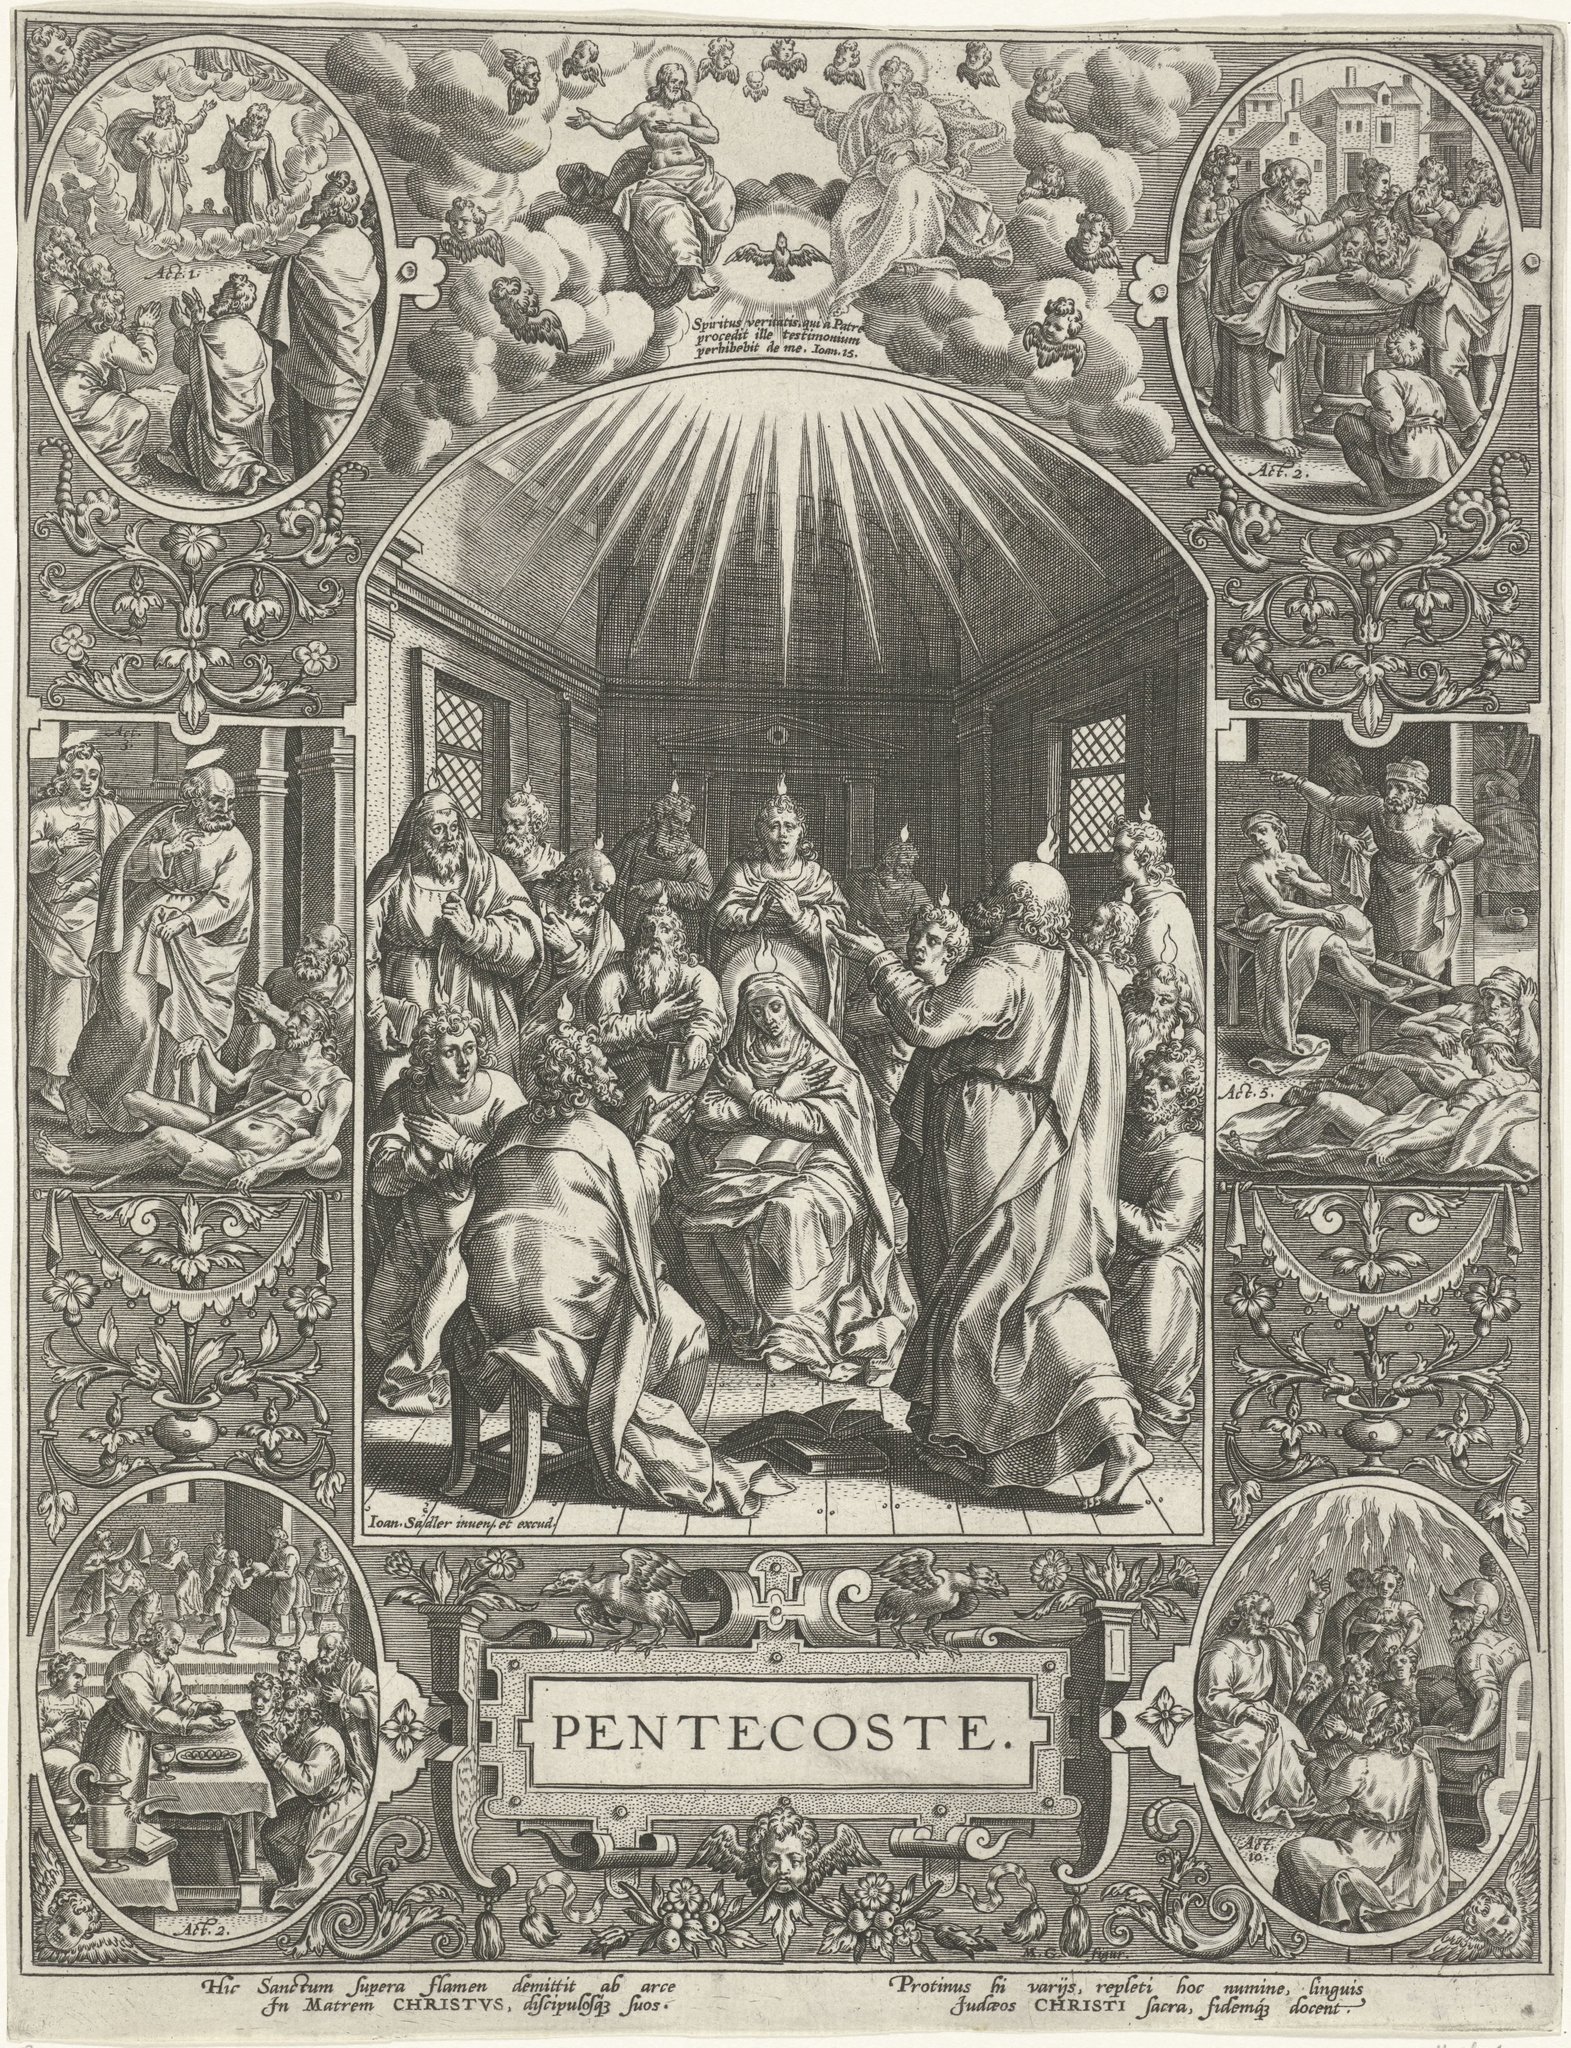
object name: print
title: Uitstorting van de Heilige Geest: Pinksteren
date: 1560-1600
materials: paper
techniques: engraving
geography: antwerp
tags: distribution of gifts by christ's disciples to every man according to his needs, peter and cornelius the centurion (acts 10), pentecost: the holy ghost descends upon (mary and) the apostles, sometimes paul and/or representatives of the nations present (acts 2:1-4) (+ holy trinity), disciples preaching and baptizing (in general), peter, john and the healed man enter the temple, where peter delivers a sermon, a multitude of the sick healed by peter and other disciples (acts 5:12-16)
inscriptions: collector's mark: Lugt 240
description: In het midden een kader met de maagd Maria, omringd door de leerlingen van Christus. Vurige tongen, als teken voor de uitstorting, branden boven hun hoofden. Boven het kader de duif van de Heilige Geest, de tronende Christus en God de Vader en een engelenkoor. Een ornamentlijst met zes scènes uit de handelingen van de apostelen.